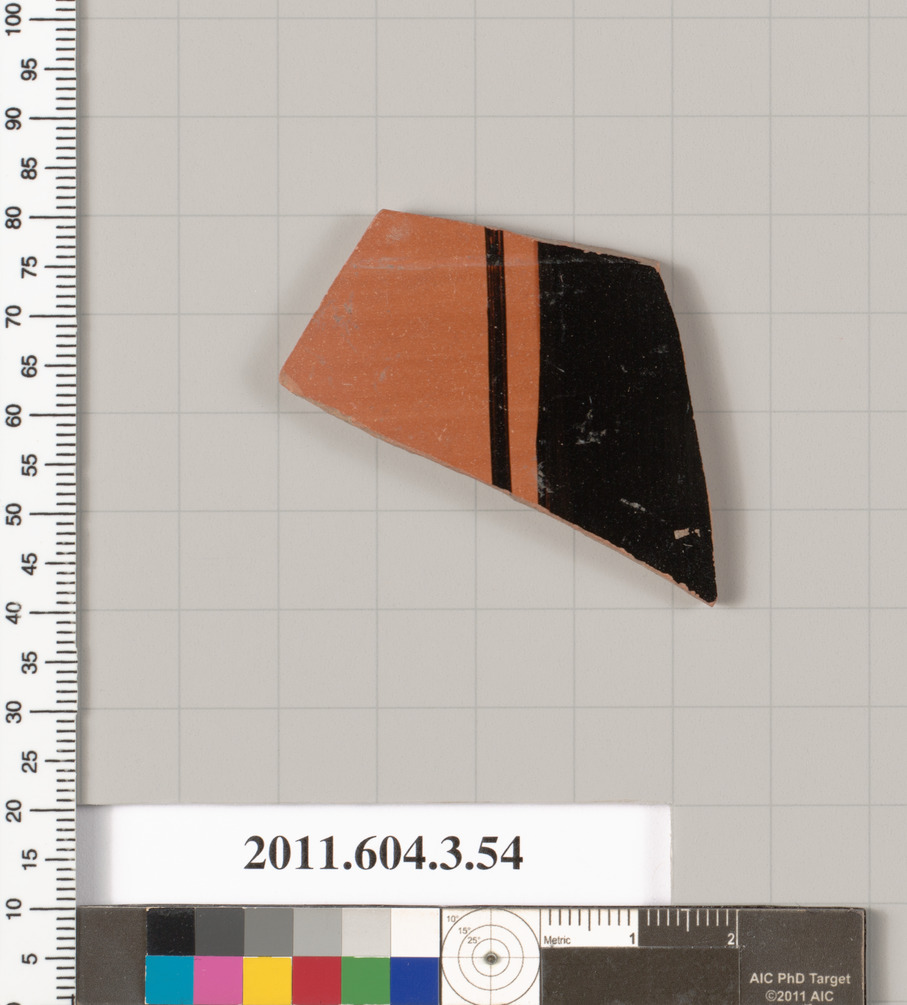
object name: amphora fragment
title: Terracotta fragment of an amphora (jar)?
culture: greek, attic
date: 550-501 BCE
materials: terracotta